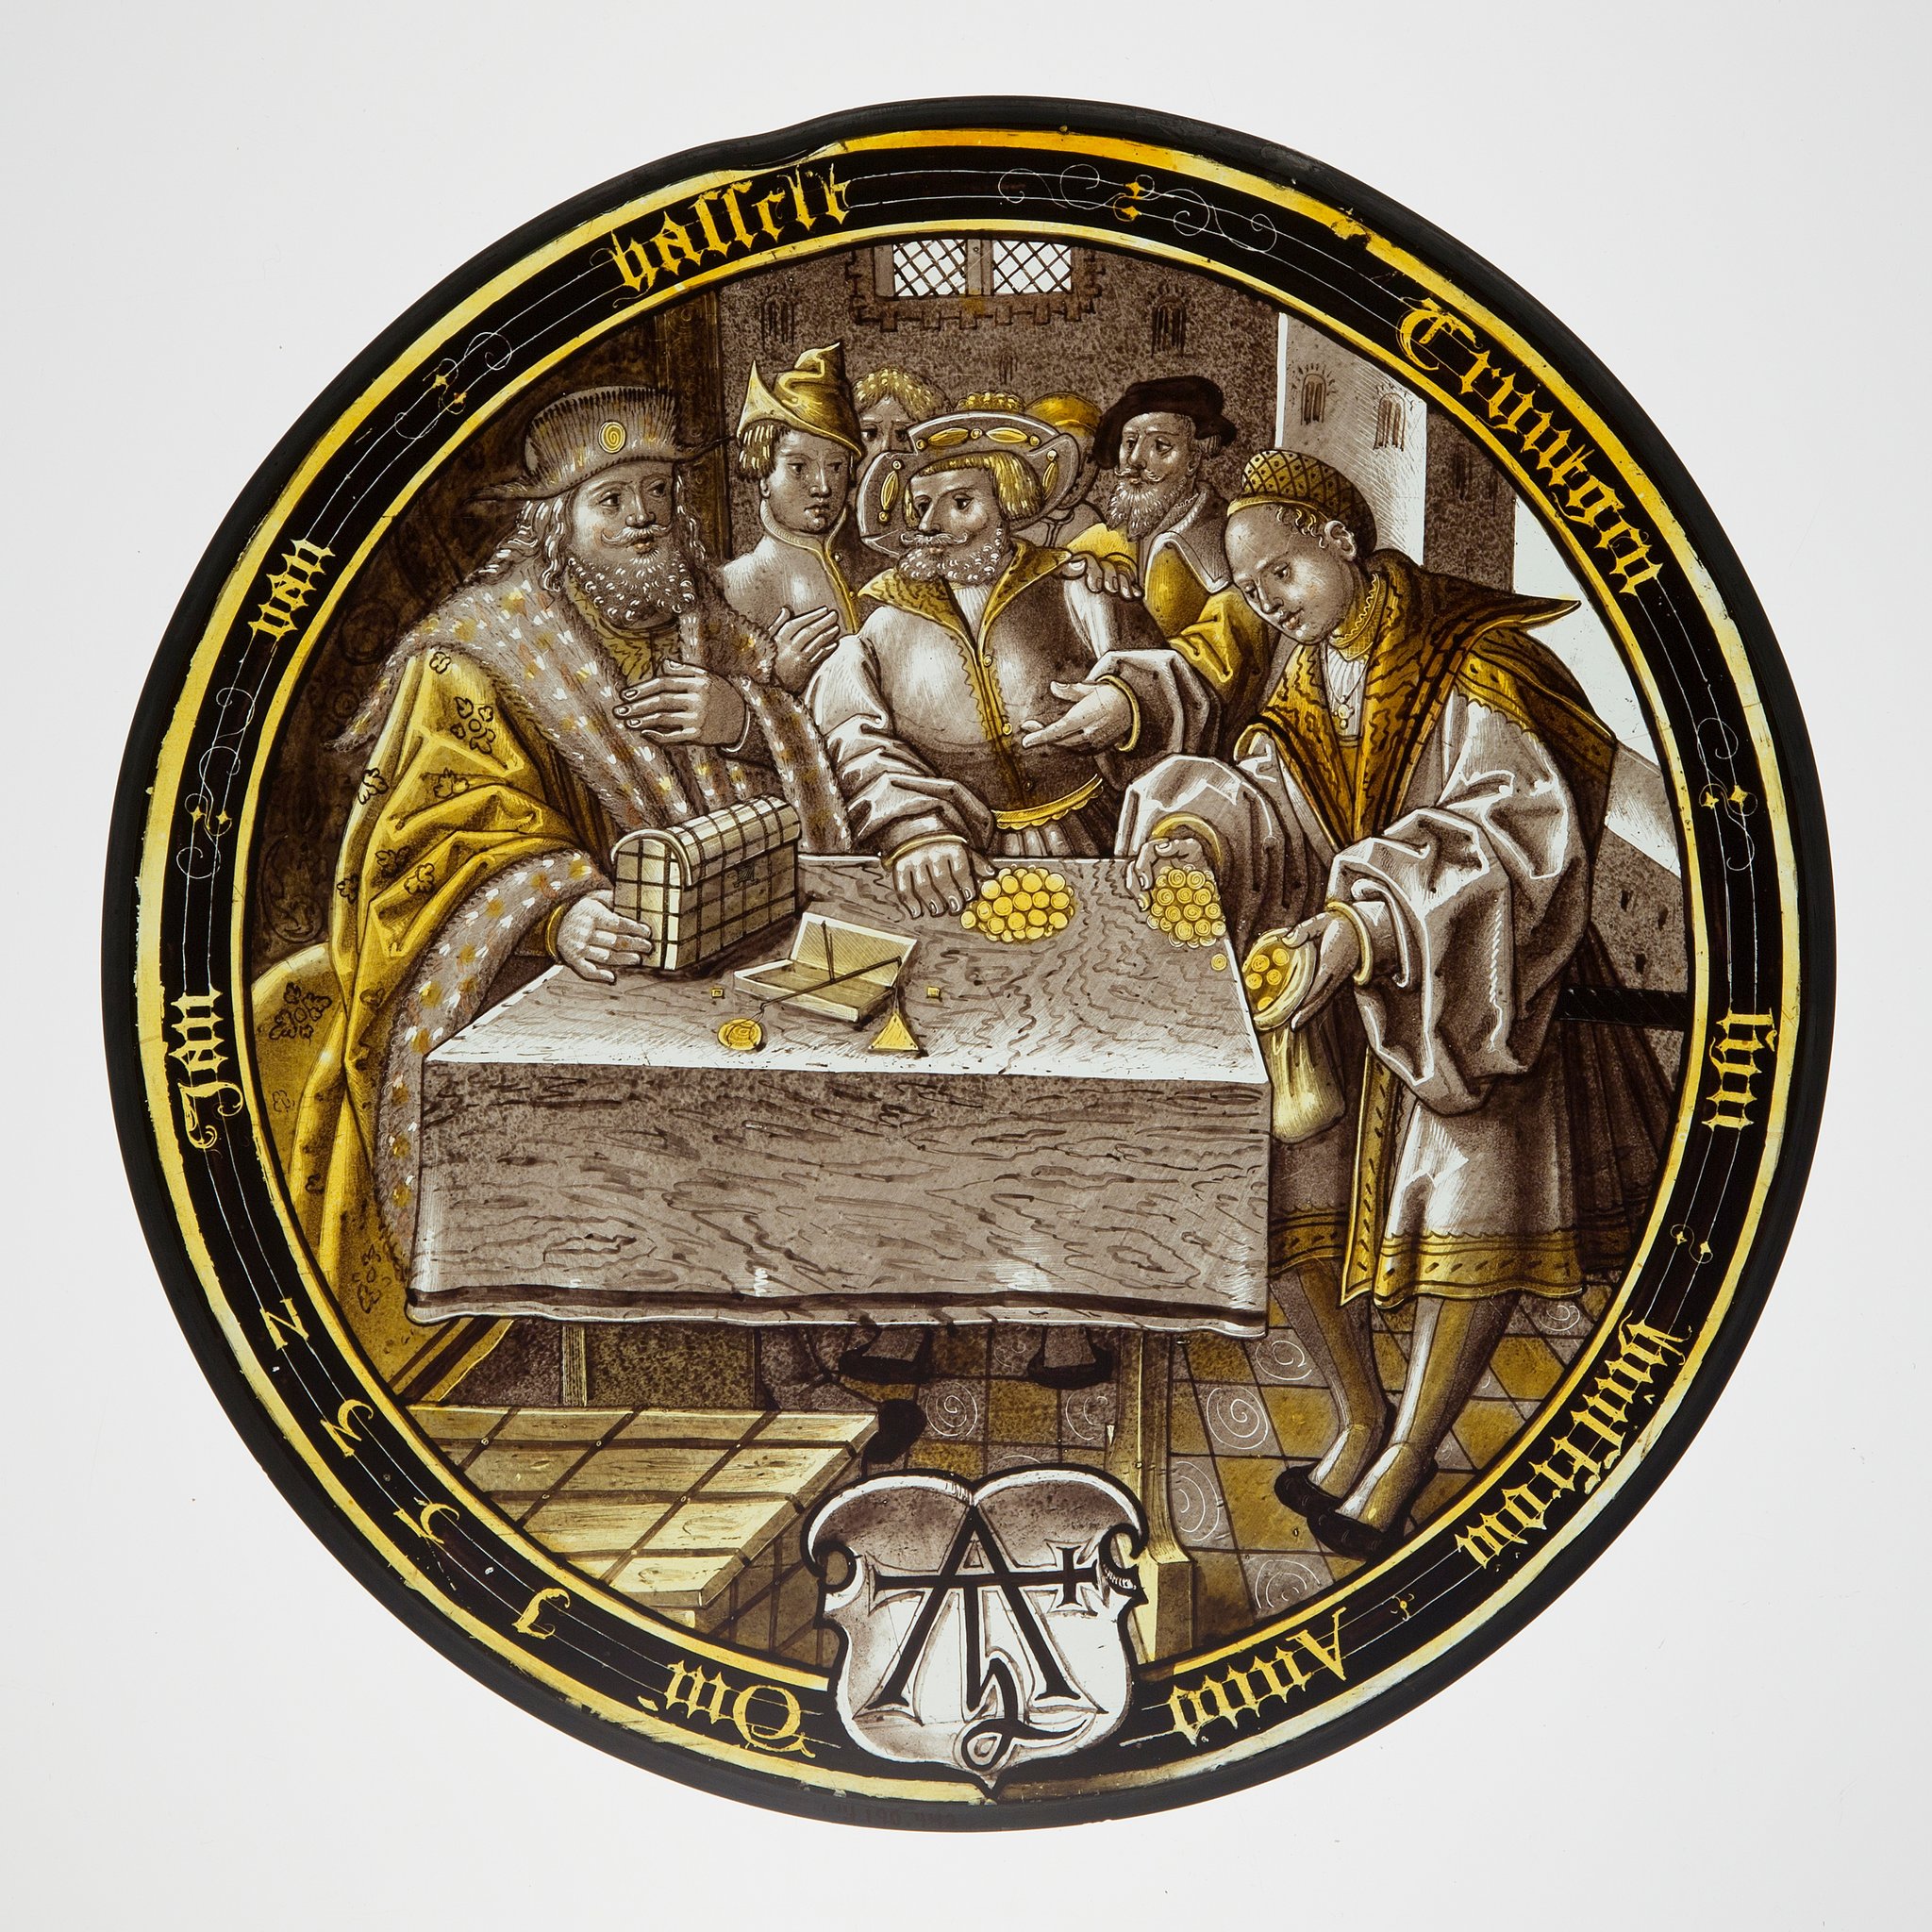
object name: roundel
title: The Prodigal Receives His Share (one of eight scenes from the story of the Prodigal Son)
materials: glass, paint, pigment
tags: men,insignia